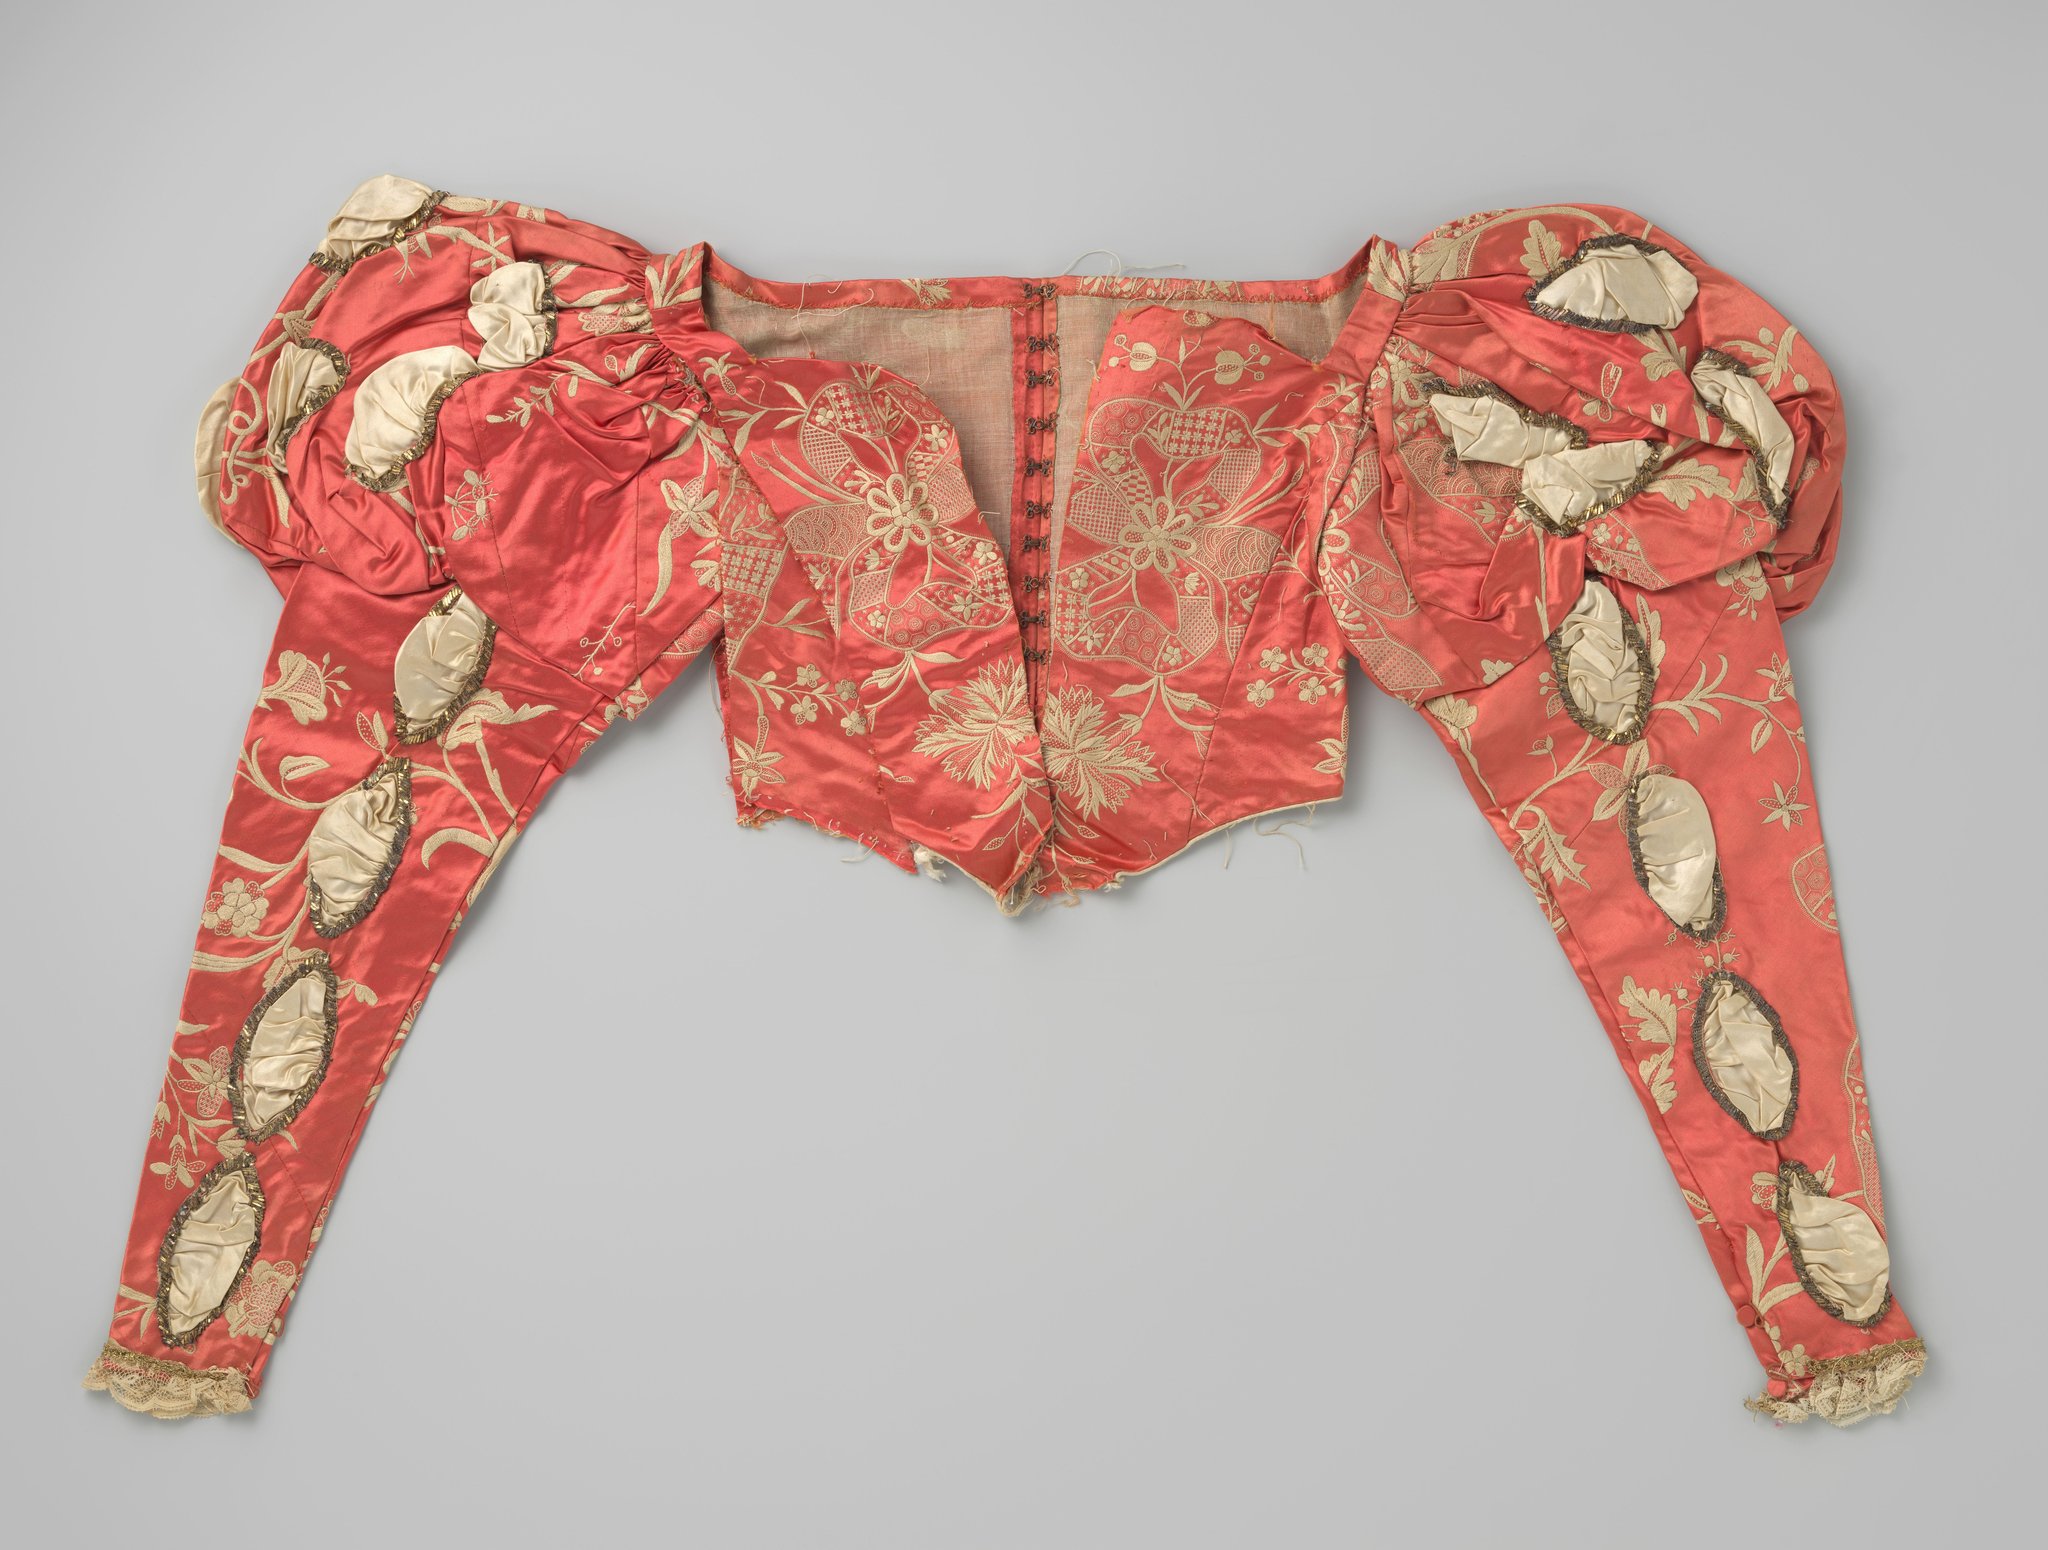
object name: corsage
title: Embroidered Interior Textile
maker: Anonymous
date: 1750-1760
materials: silk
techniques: embroidered, weave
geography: france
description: Aan de binnenkant van de achterzijde sluit het lijfje met tien haken en ogen van metaal.